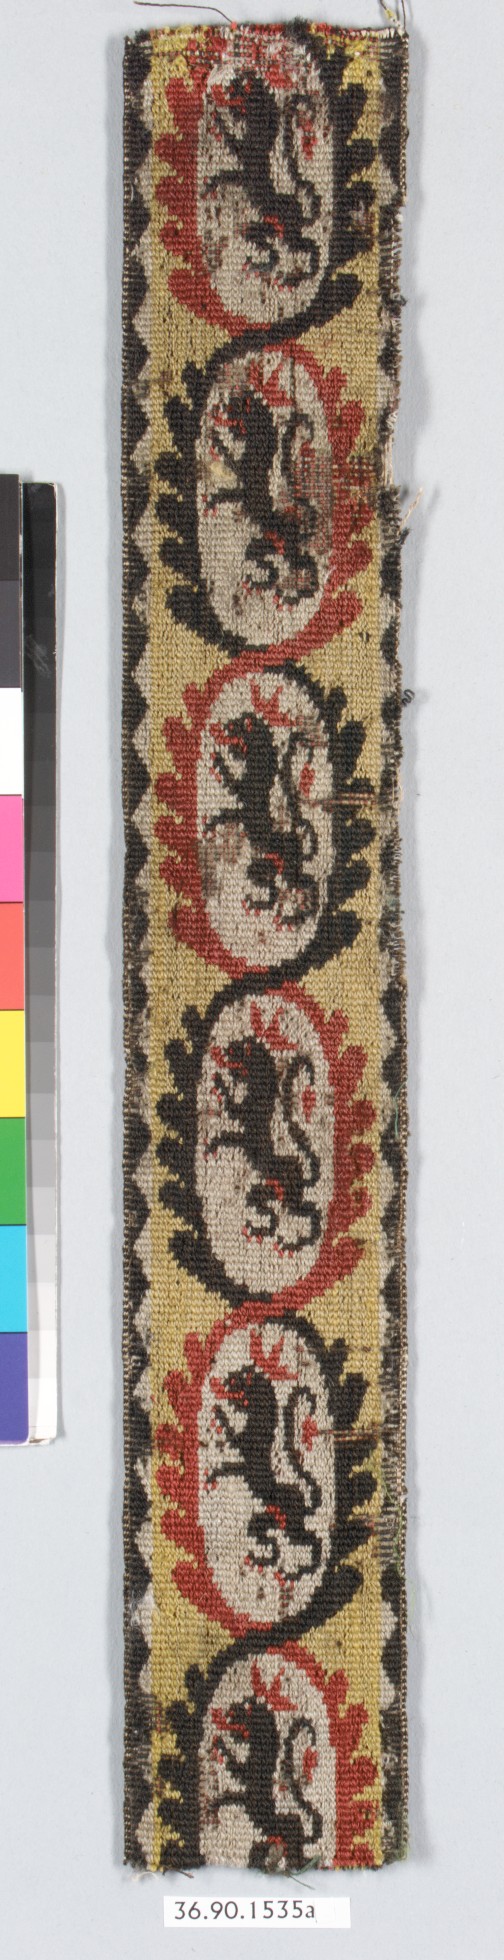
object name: galloon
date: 1701-1900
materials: wool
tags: lions